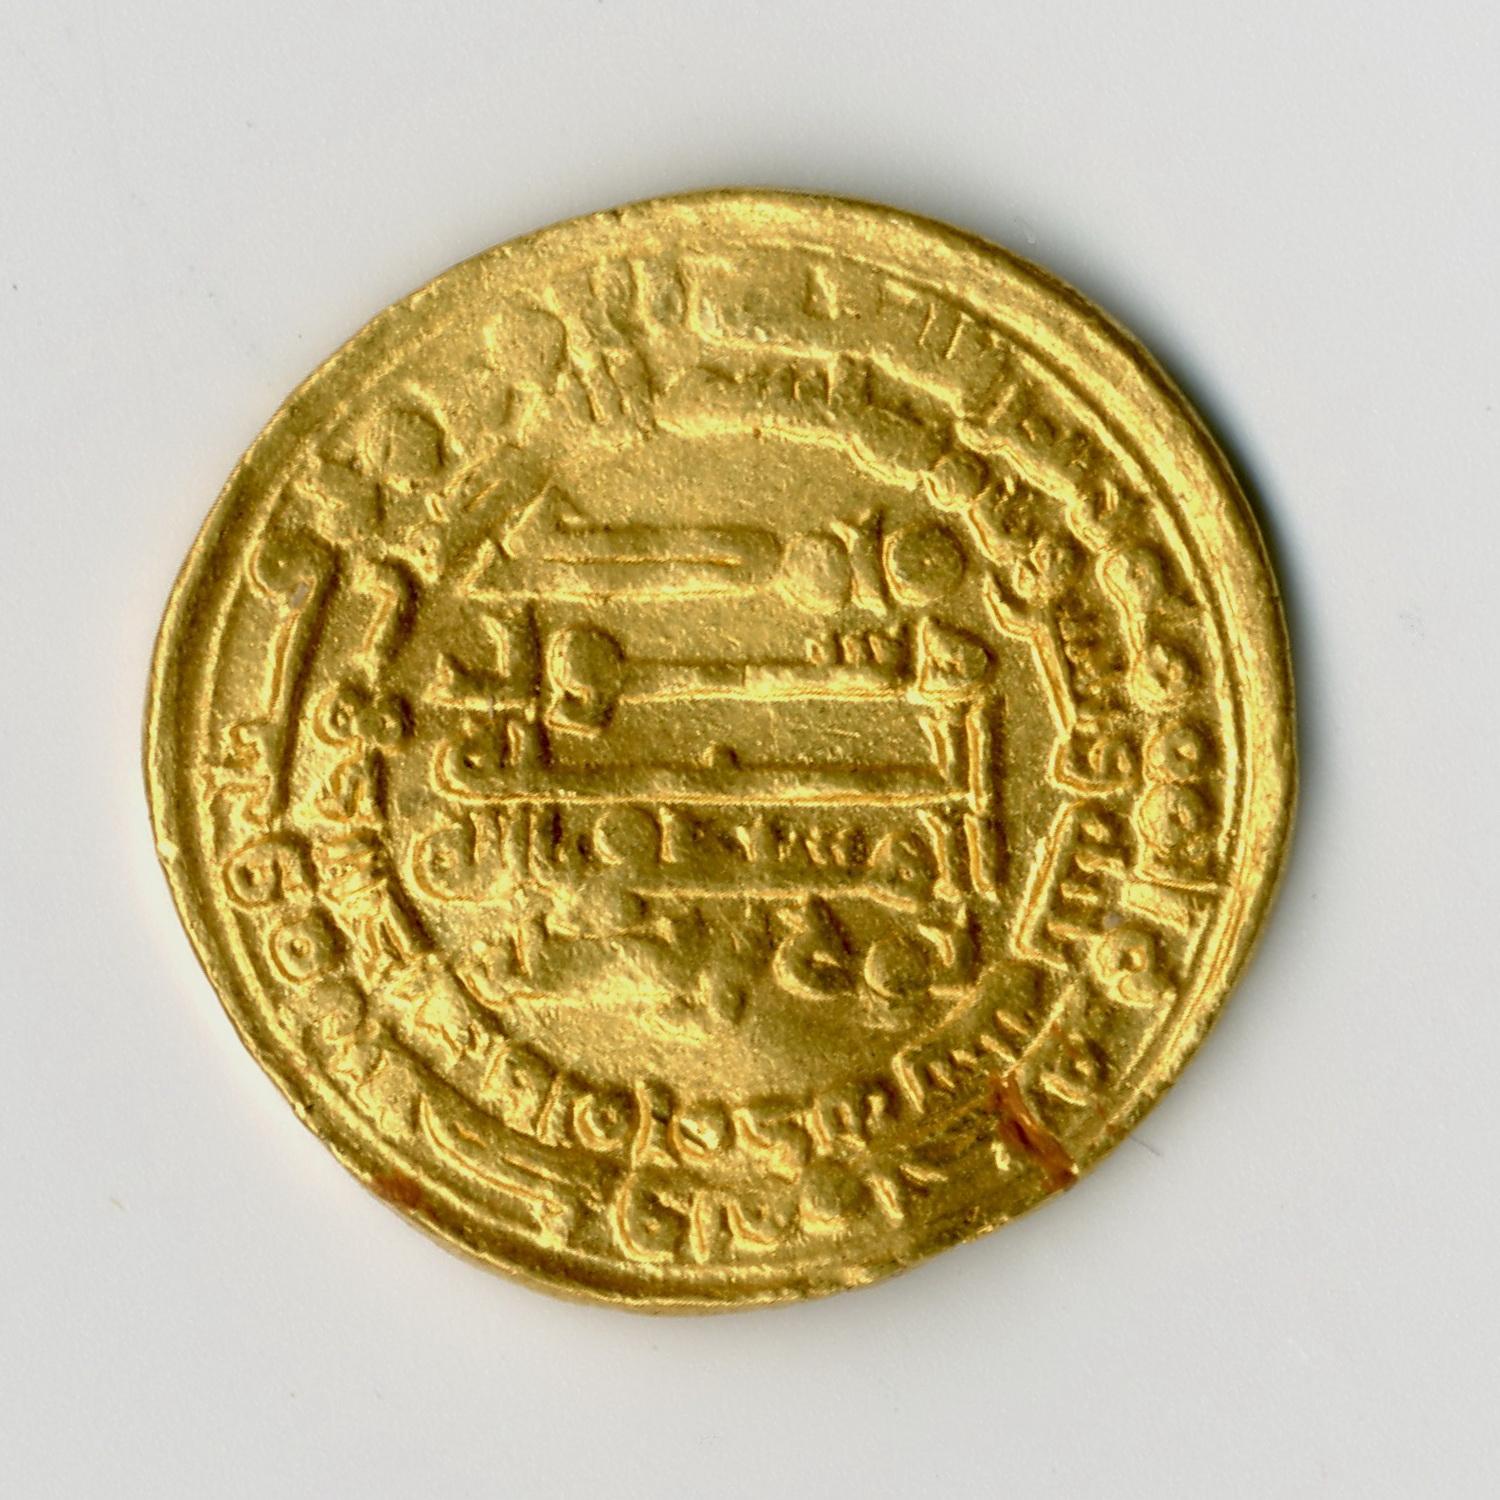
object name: coin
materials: gold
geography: iran